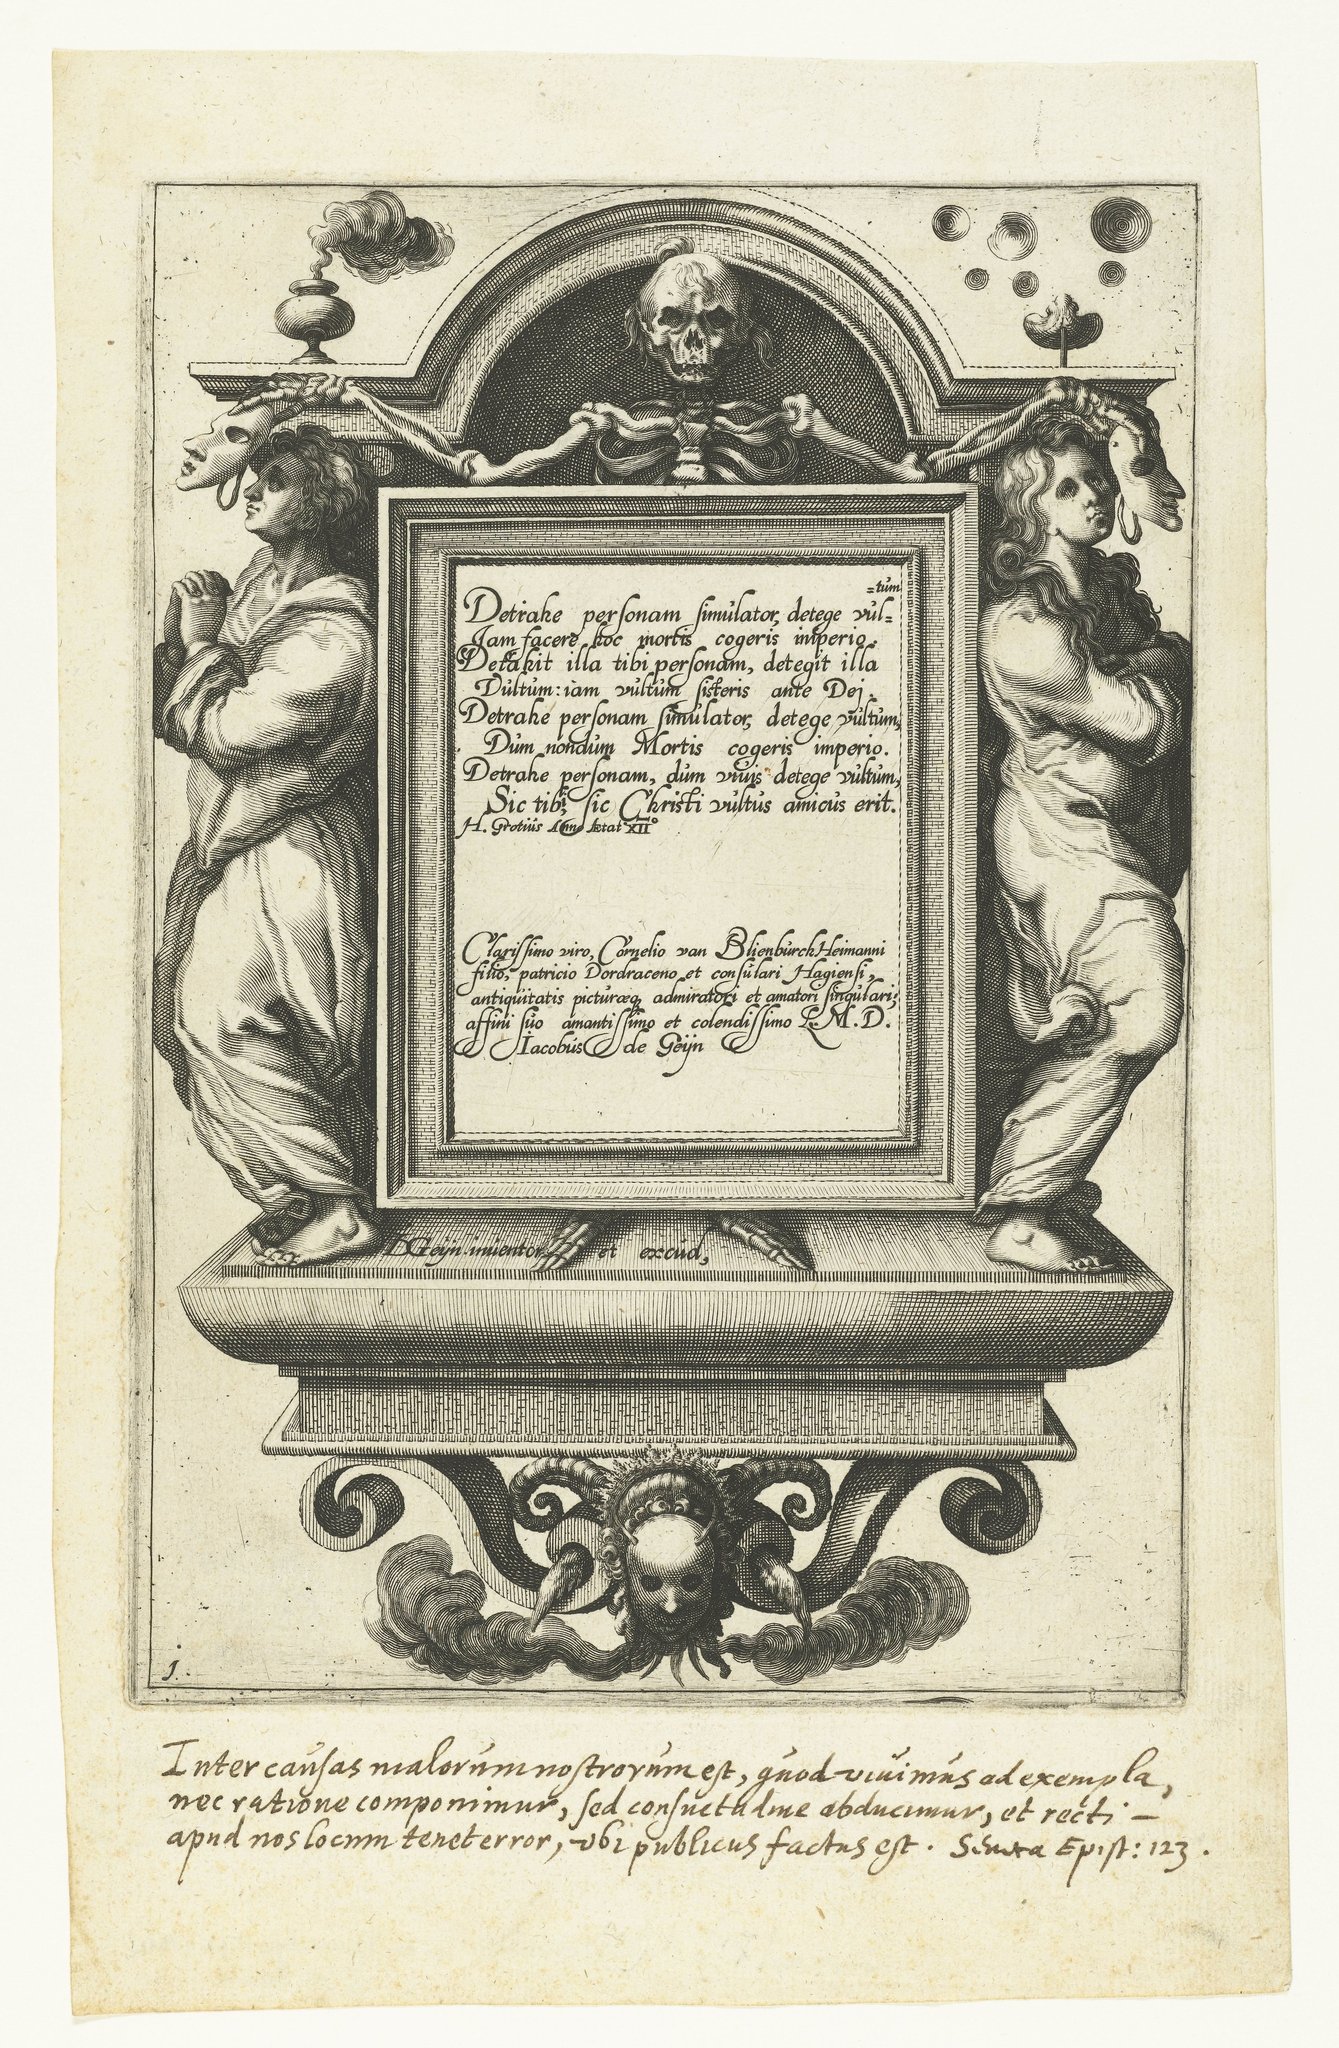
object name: print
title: Titelprent voor prentserie De maskerades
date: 1595-1596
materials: paper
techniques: engraving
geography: leiden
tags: mask, death as skeleton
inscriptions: collector's mark: Lugt 2228a, inscription: ‘Inter cansas ... Epist: 123’, collector's mark: Lugt 3790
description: Een Latijnse tekst in een cartouche, waarboven een skelet uitkomt. Dit skelet houdt een masker voor de gezichten van de twee figuren die tegen de linker- en de rechterzijde van de cartouche geleund staan. Deze prent is onderdeel van een serie van tien genummerde prenten: een titelprent en negen prenten waarop twee of drie gemaskerde en/of verklede figuren ten voeten uit zijn weergegeven.